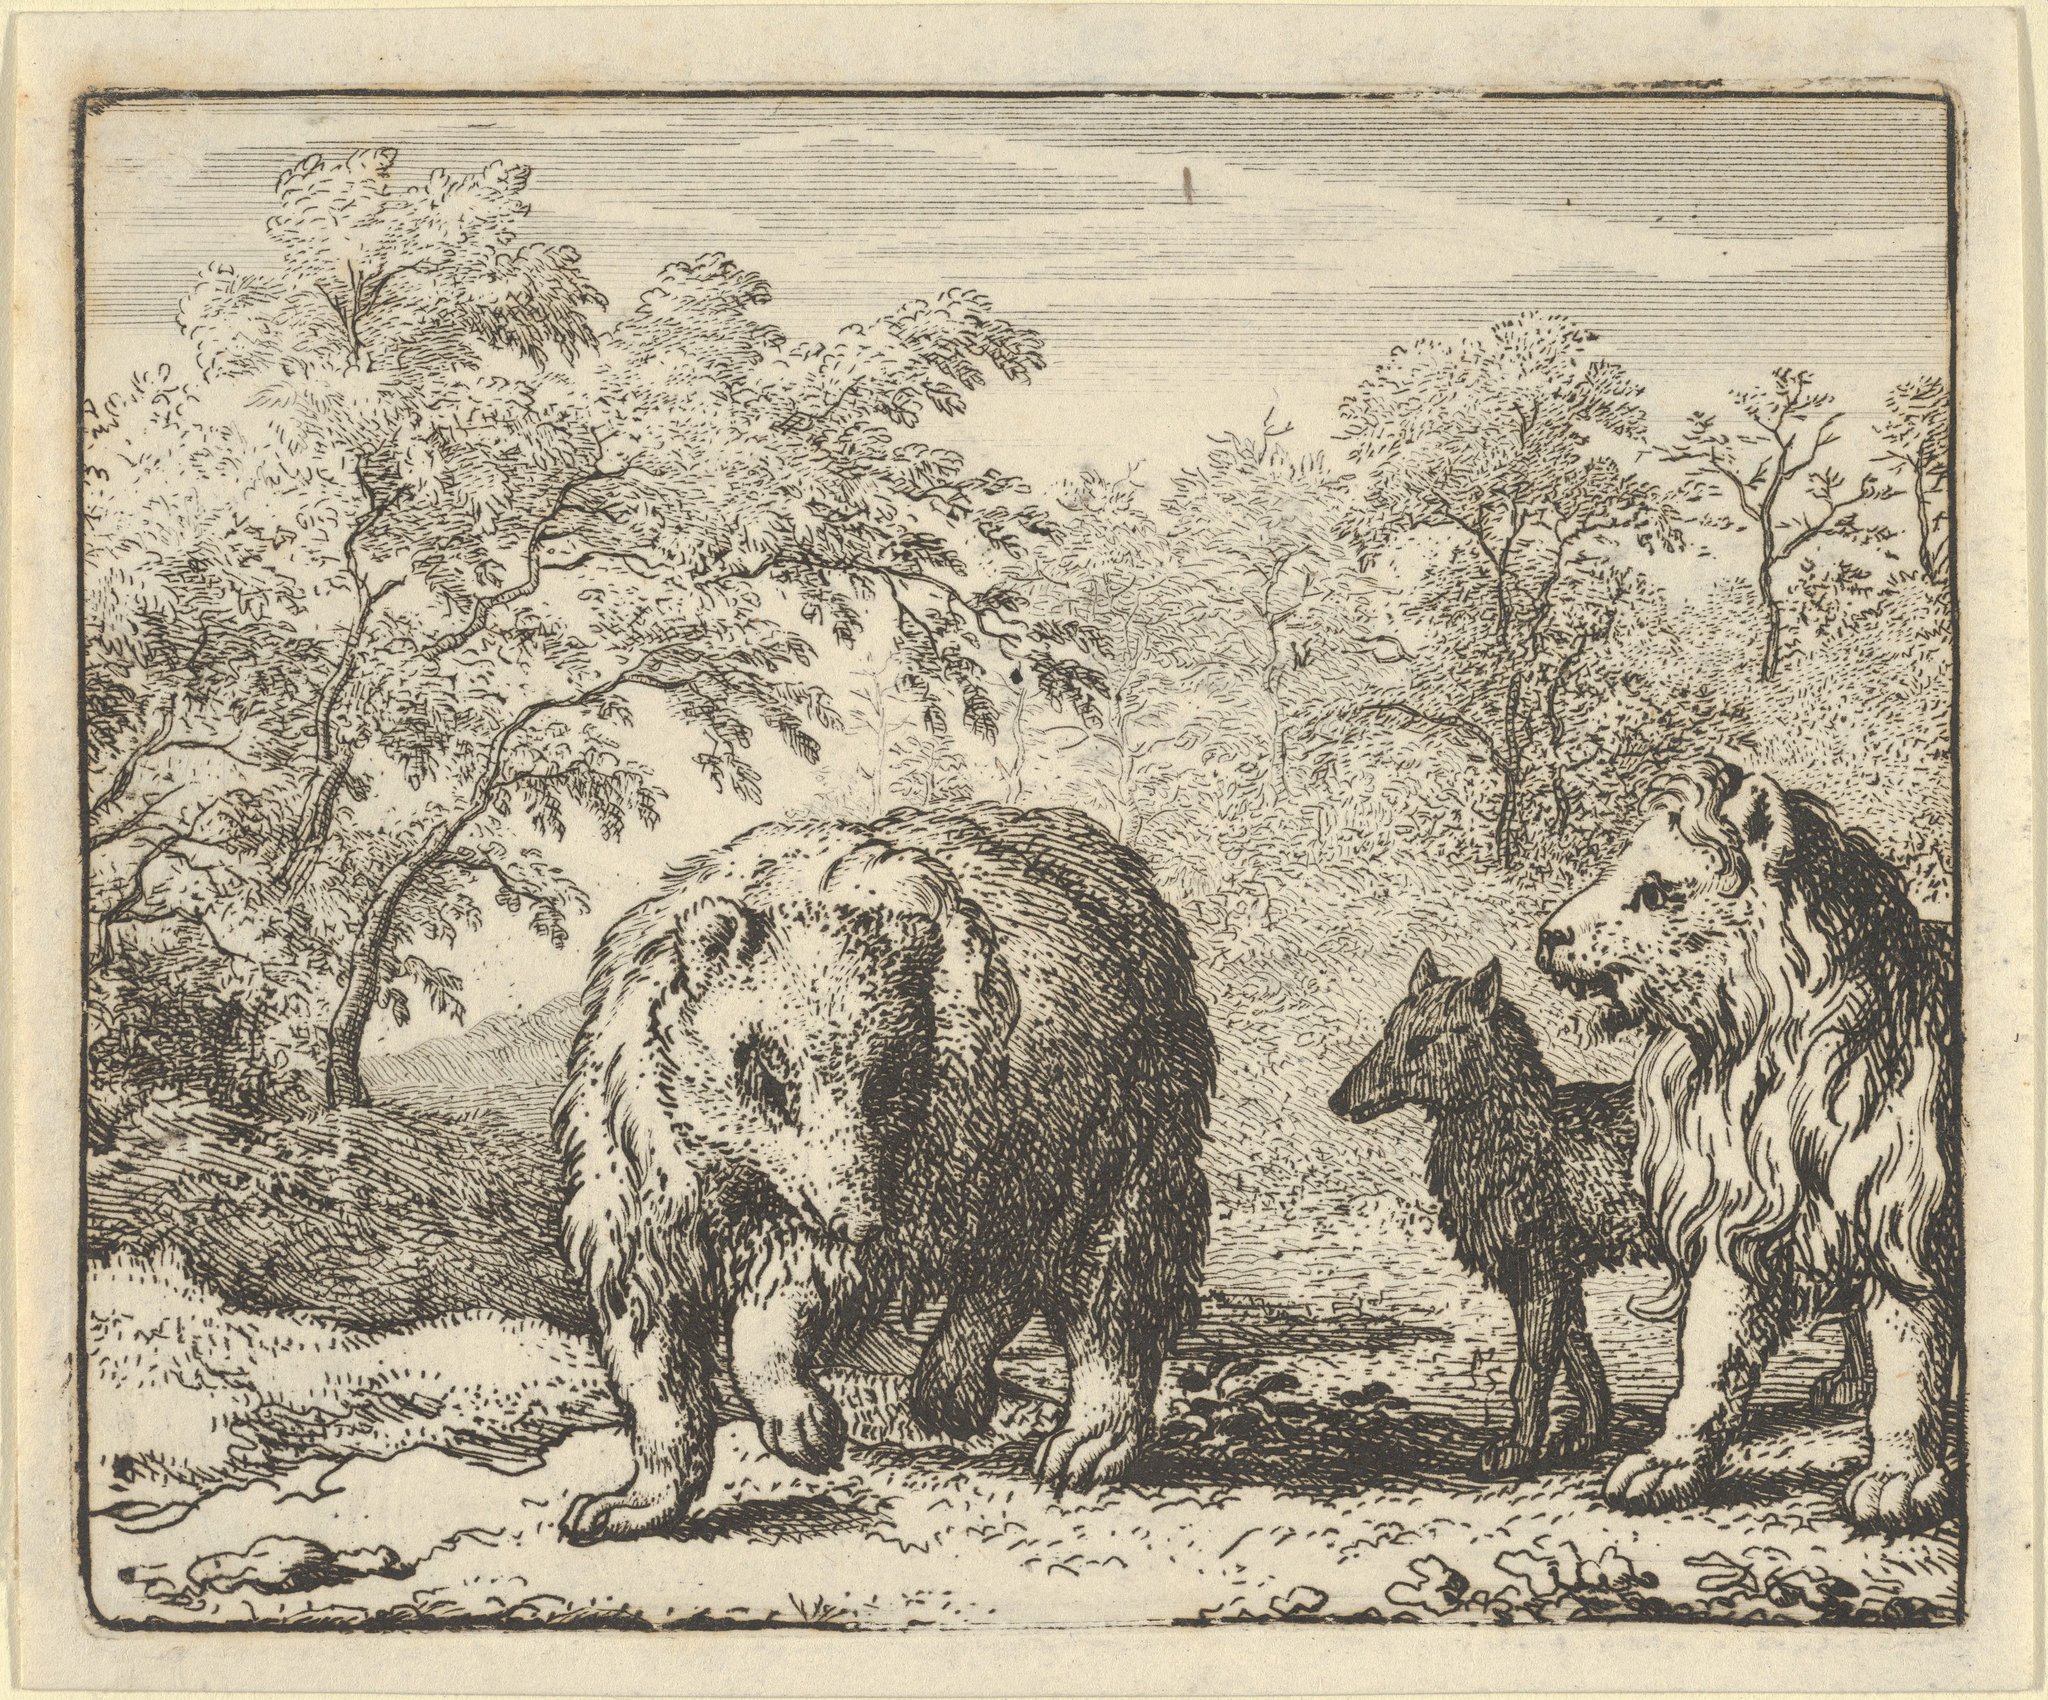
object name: print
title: The Lion Frees the Bear and the Wolf from Hendrick van Alcmar's Renard The Fox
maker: allart van everdingen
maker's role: artist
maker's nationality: dutch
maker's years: 1621-1675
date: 1650-1675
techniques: engraving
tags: bears,foxes,lions